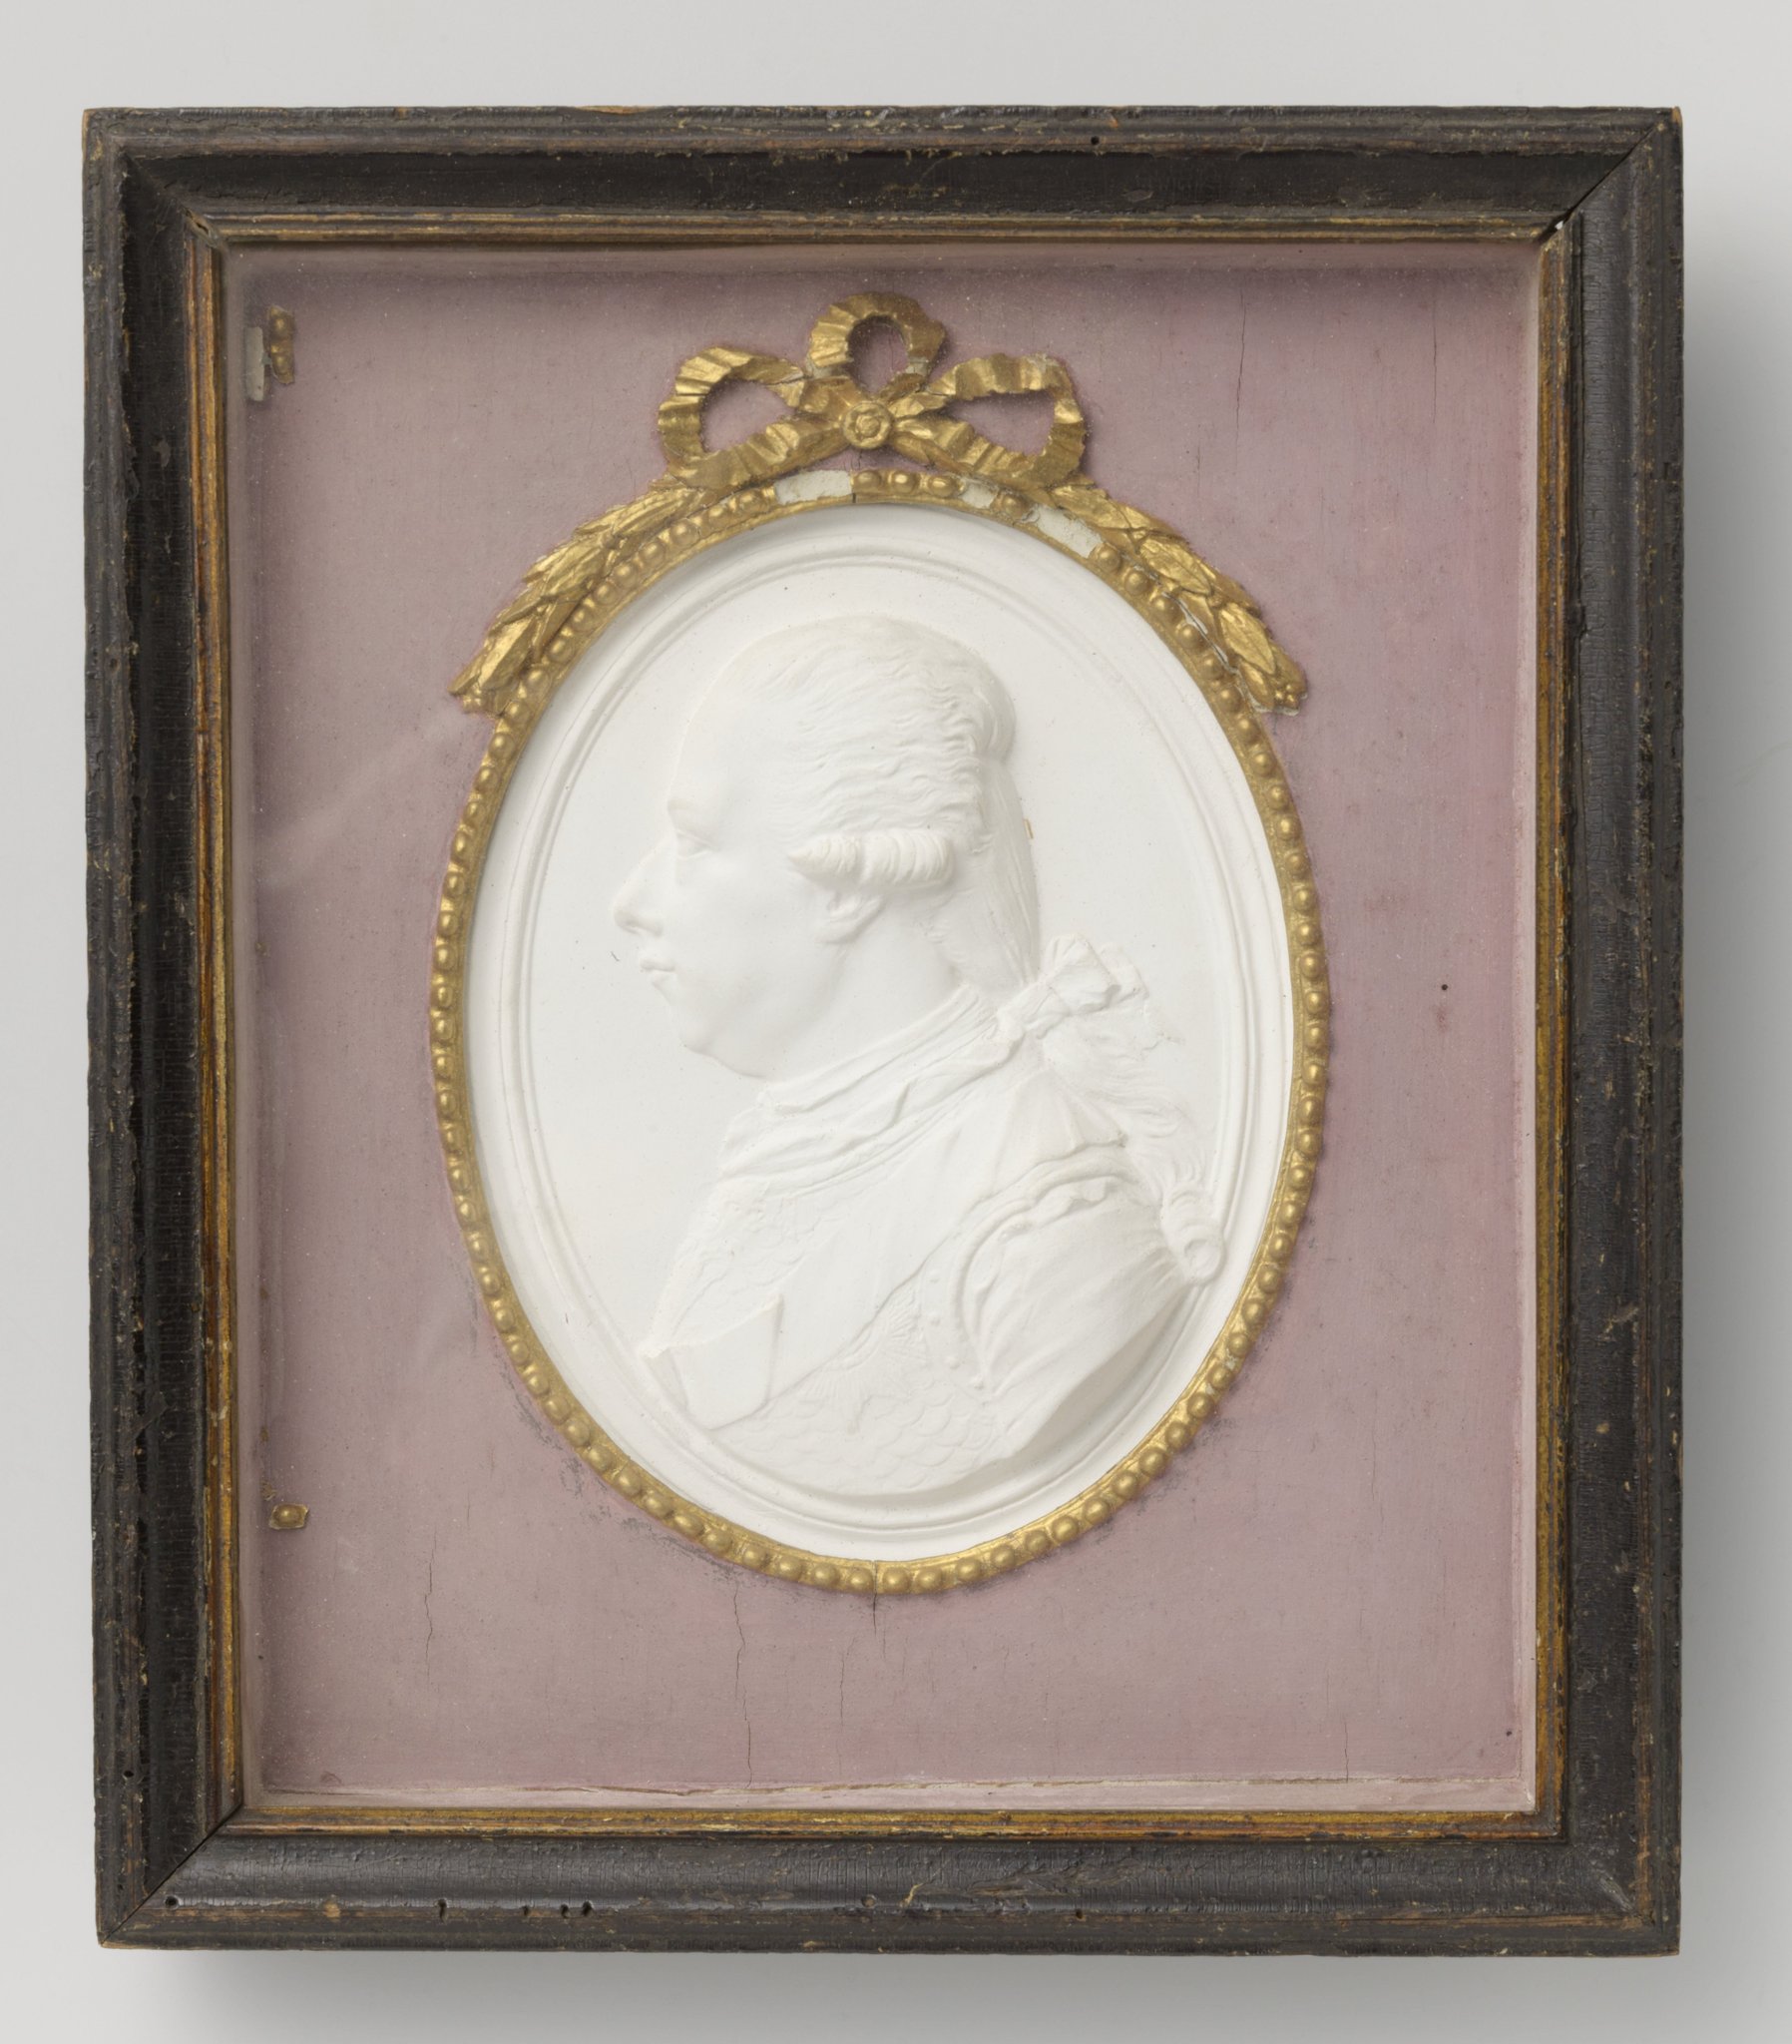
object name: locket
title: Medaillonportret van Willem V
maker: johann heinrich schepp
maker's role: sculptor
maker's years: 1736-1811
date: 1782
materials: glass, gypsum, wood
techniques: casting, framing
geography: the hague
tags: william v (prince of orange), historical persons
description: Medaillonportret in gips, borstbeeld naar links in profiel (Willem V), in uniform met ereteken op linkerborst en met pruik, met geprofileerde rand. In binnenlijst van verguld (gips?), parelrand met aan bovenzijde strik en afhangende lauwertakken. Hierom lichte violette omraming, die weer in zwarte houten lijst met verguld binnenrandje zit; achter glas.